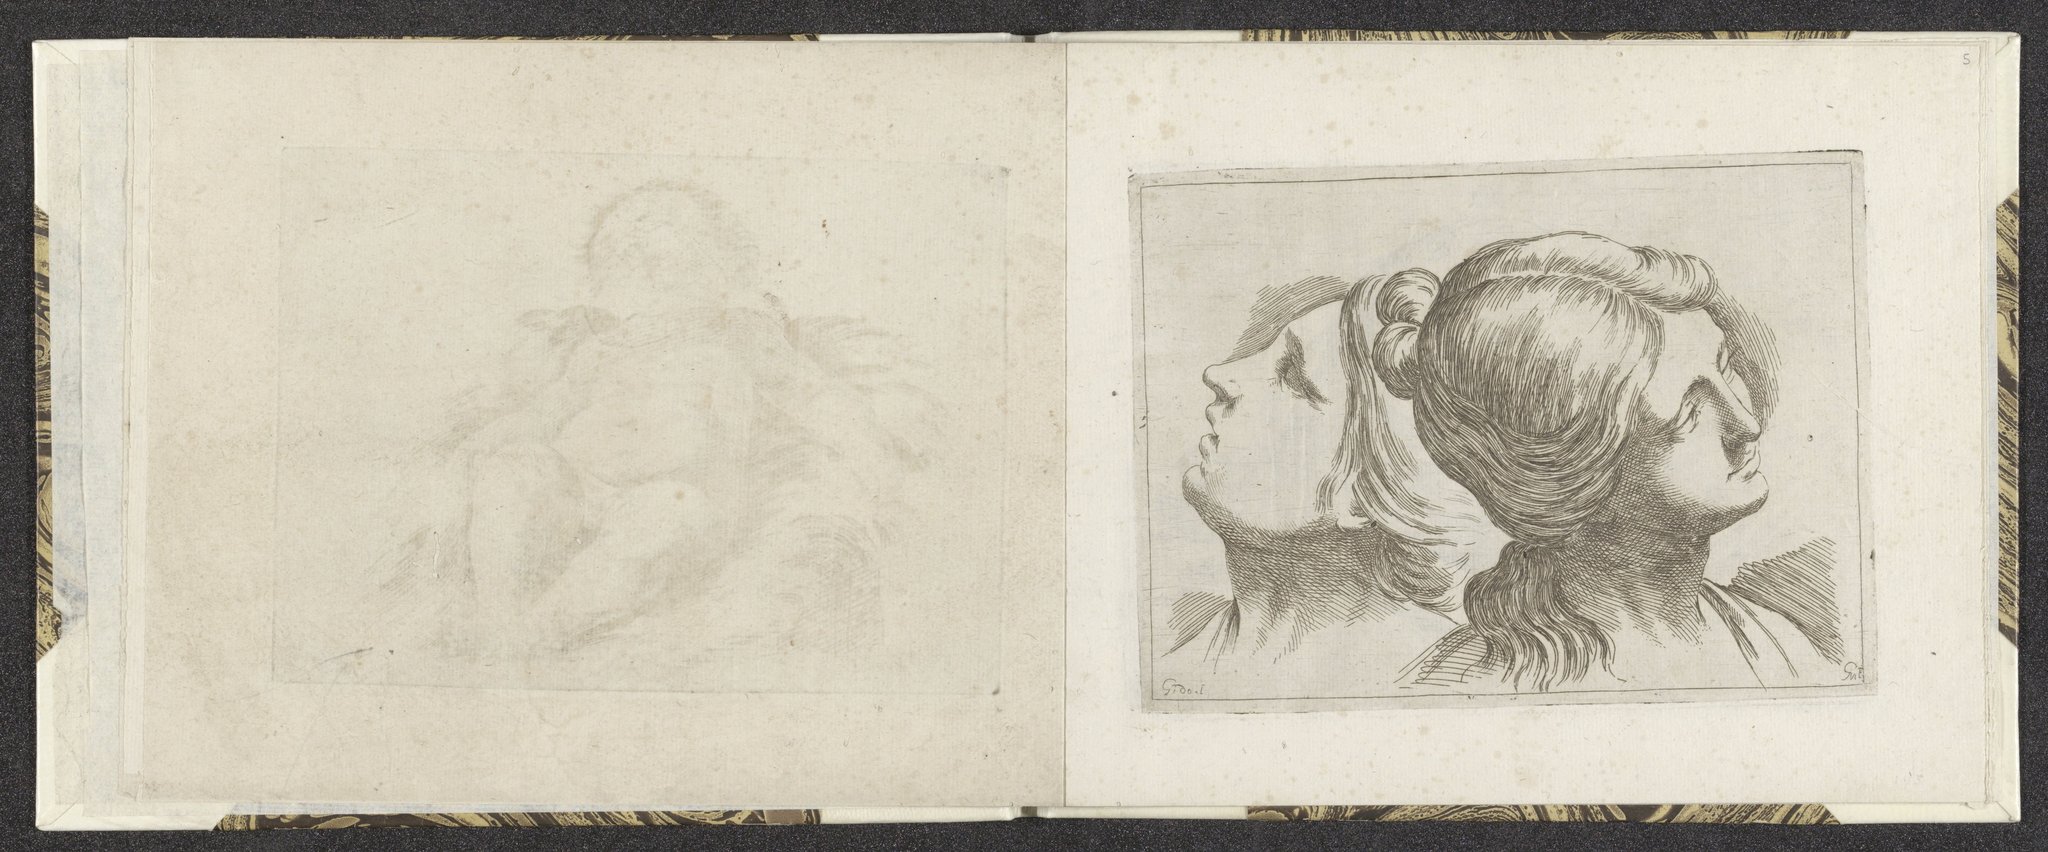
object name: print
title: Tekenvoorbeelden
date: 1663-1666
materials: paper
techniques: etching, intaglio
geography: italy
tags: face, model-books ~ implements of painter